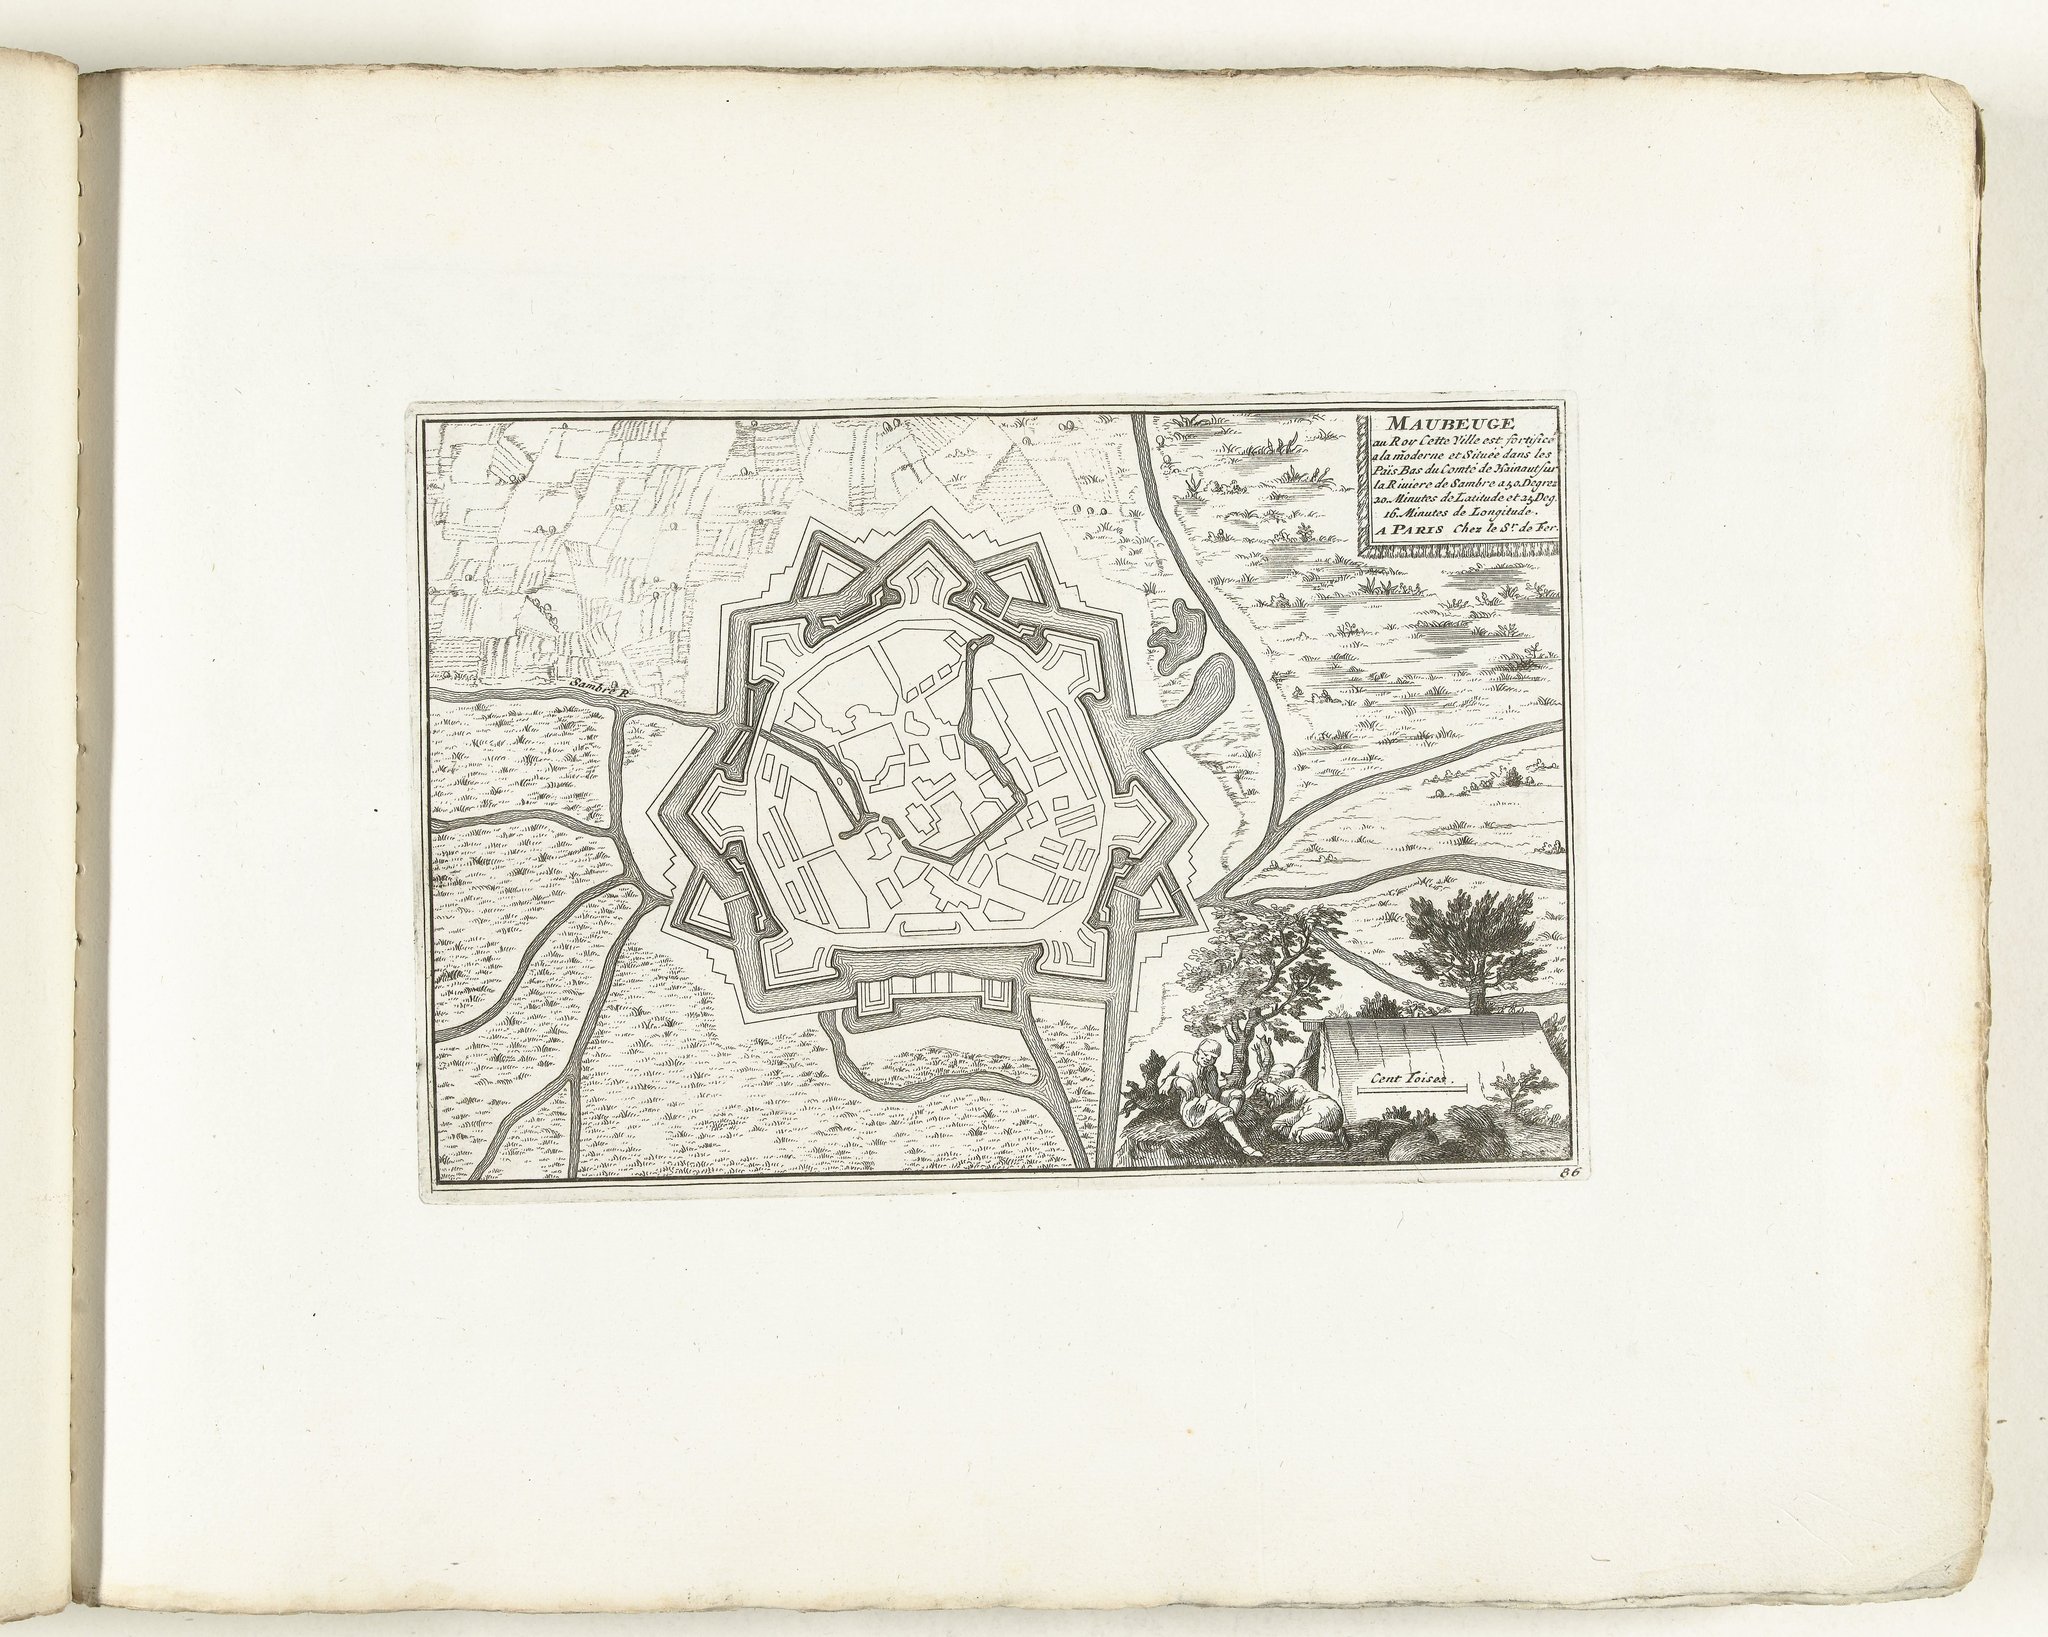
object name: print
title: Plattegrond van Maubeuge, ca. 1702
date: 1702-1703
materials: paper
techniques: etching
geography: northern netherlands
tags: fortress, maps of cities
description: Plattegrond van de versterkingen om de stad Maubeuge in de graafschap Henegouwen. Plaat nr. 86 in het prentwerk bestaande in totaal uit 276 genummerde platen van vermaarde sterke steden en vestingen in het kader van de Spaanse Successieoorlog. Voor het merendeel zijn deze platen gekopieerd naar de anonieme Franse platen: in Les forces de l'Europe en in: Le theatre de la guerre, dans les Pays-Bas, beide oorspronkelijk uitgegeven door Nicolas de Fer te Parijs (1693-1697) in het kader van de Negenjarige Oorlog. Titels en opschriften in de plaat in het Frans.